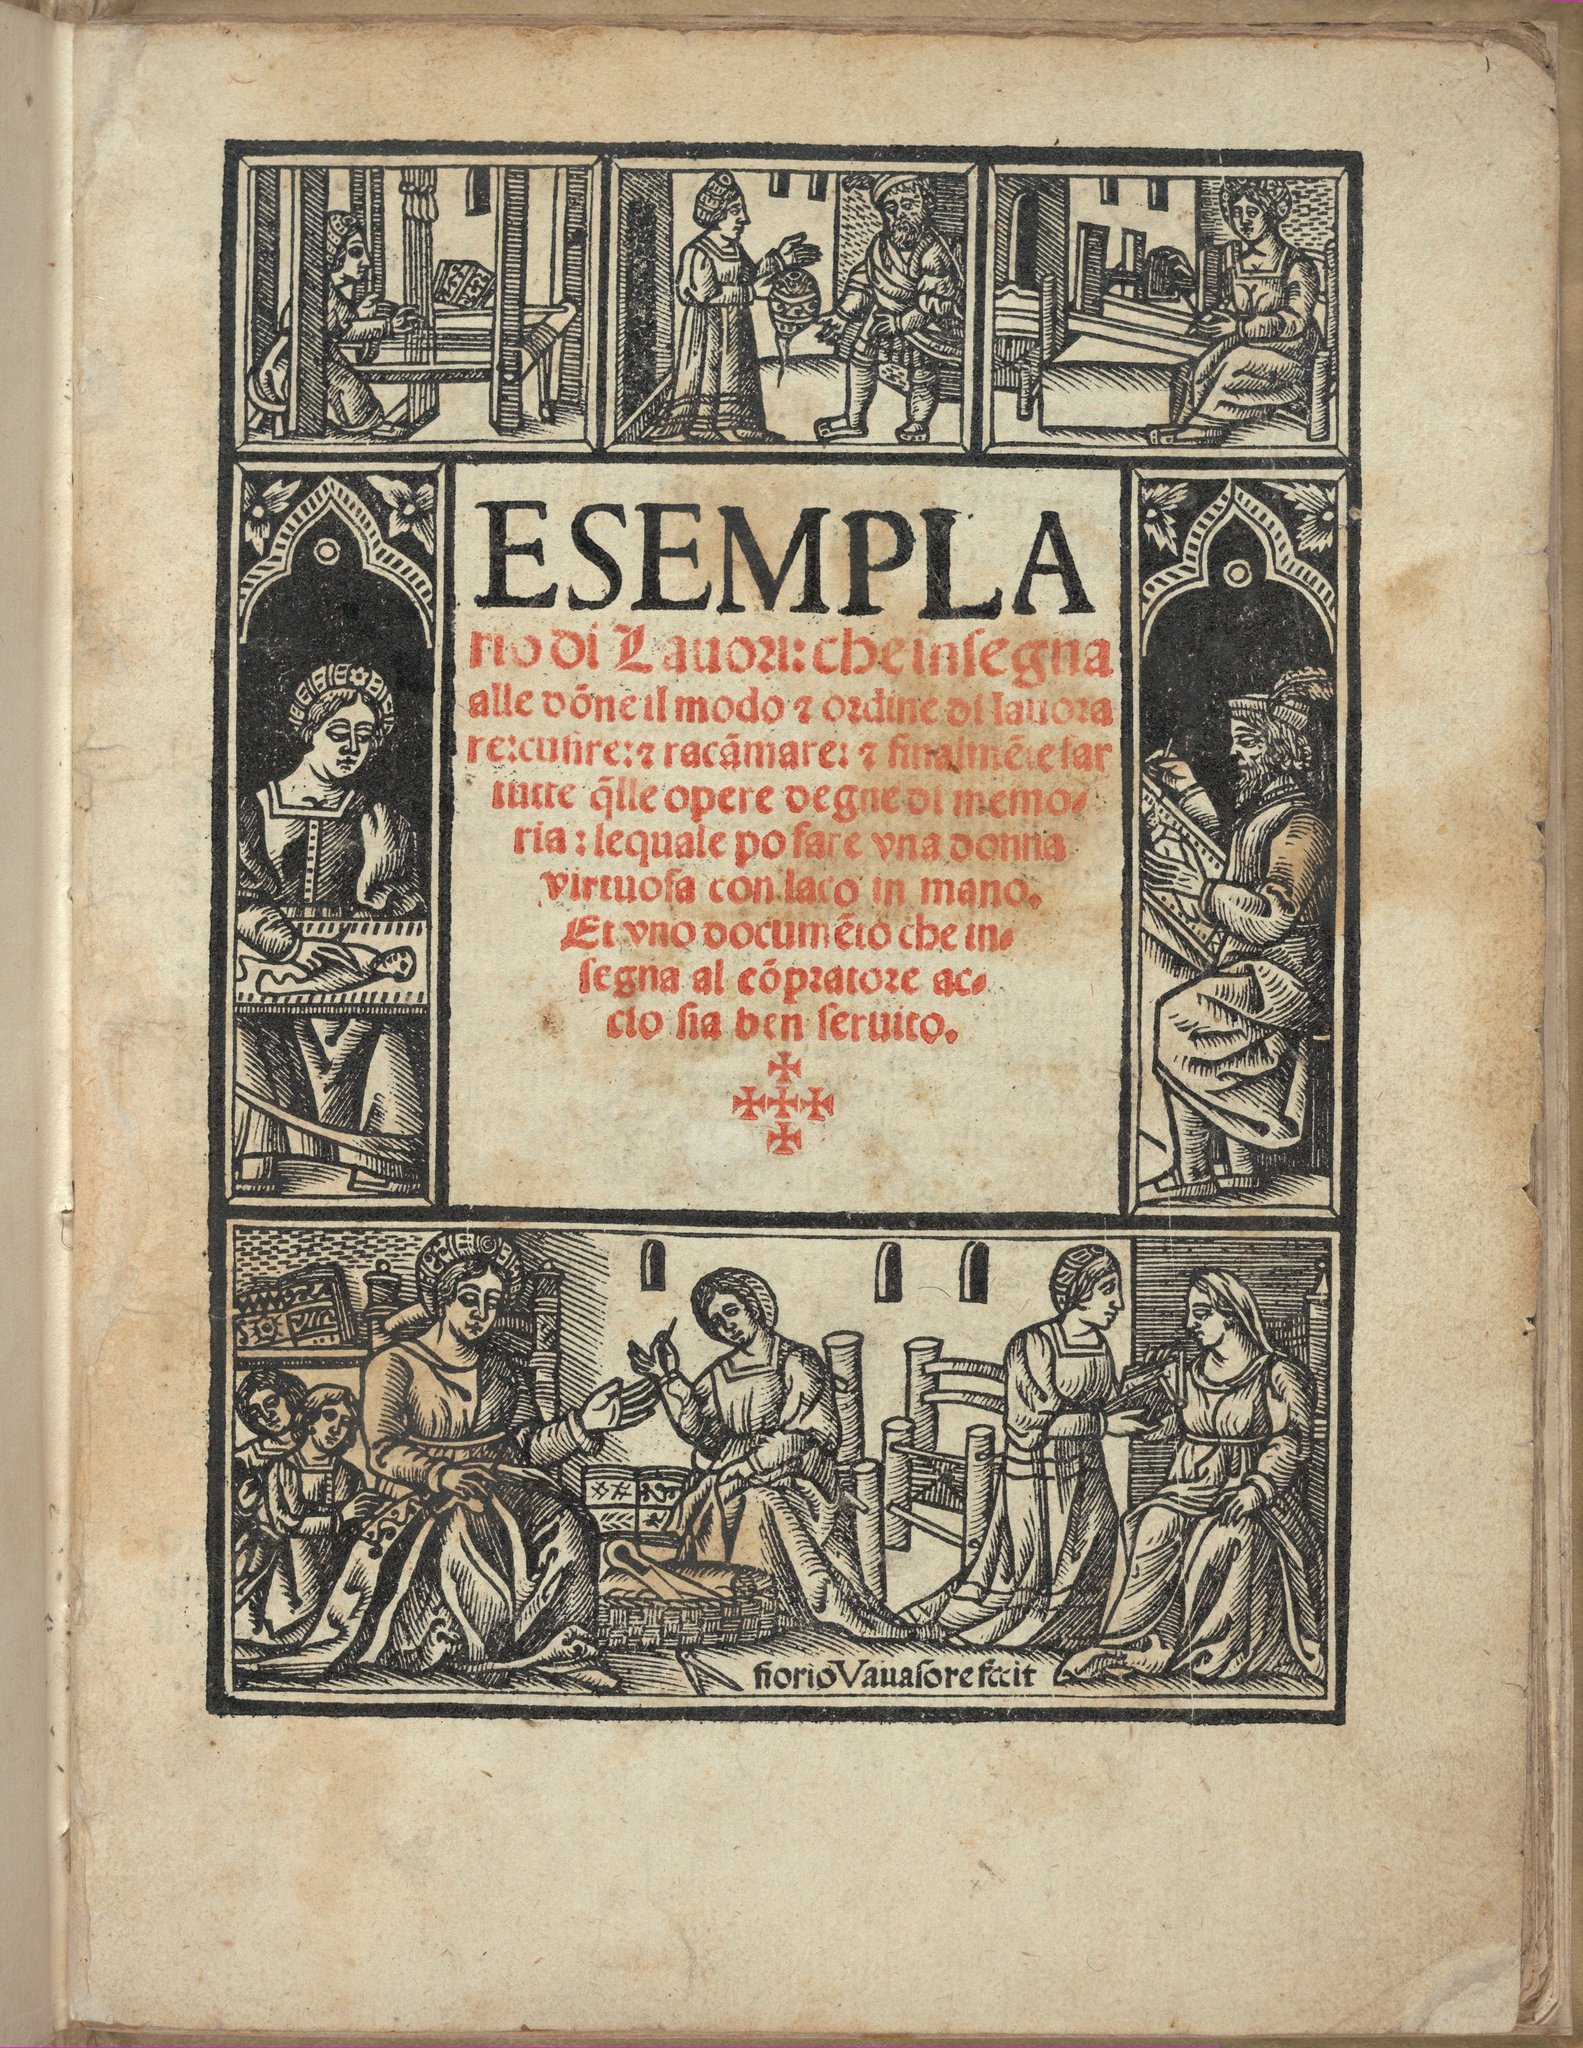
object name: book print ornament architecture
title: Esemplario di Lauori...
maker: giovanni andrea vavassore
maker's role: publisher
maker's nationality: italian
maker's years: 1530-1573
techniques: woodcut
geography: venice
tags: men,women